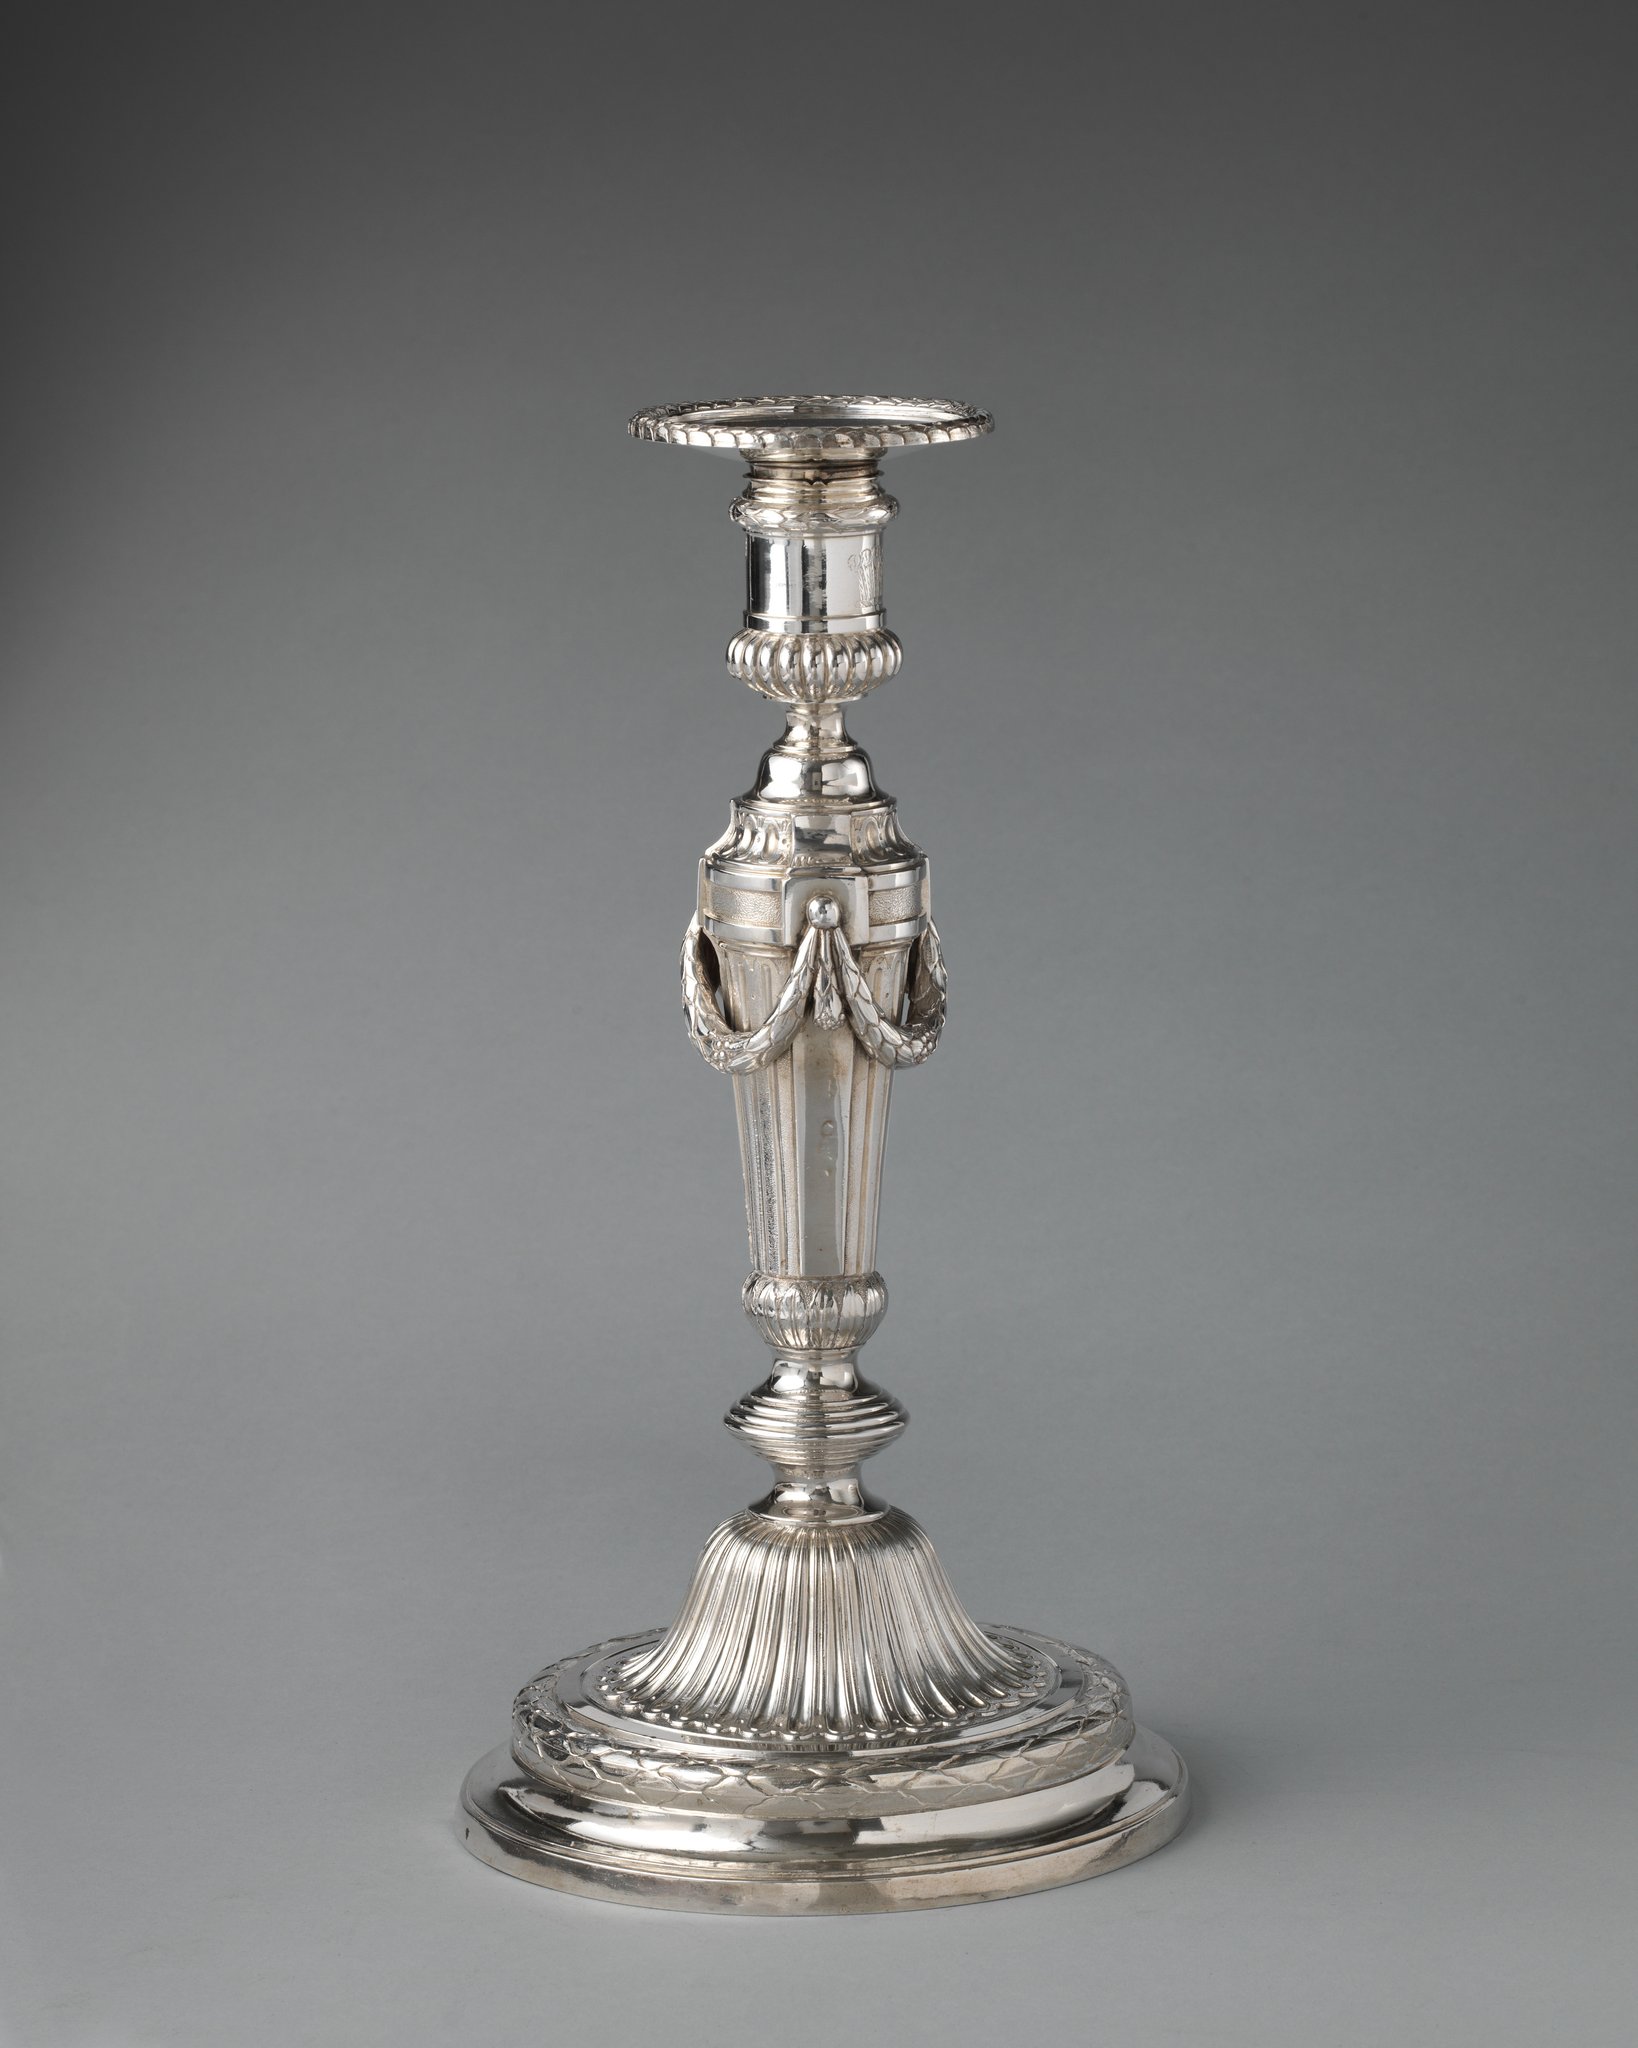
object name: candlestick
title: Candlestick (one of a set of eight)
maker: john romer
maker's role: maker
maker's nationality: british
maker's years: 1712-1815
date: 1768-1769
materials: silver